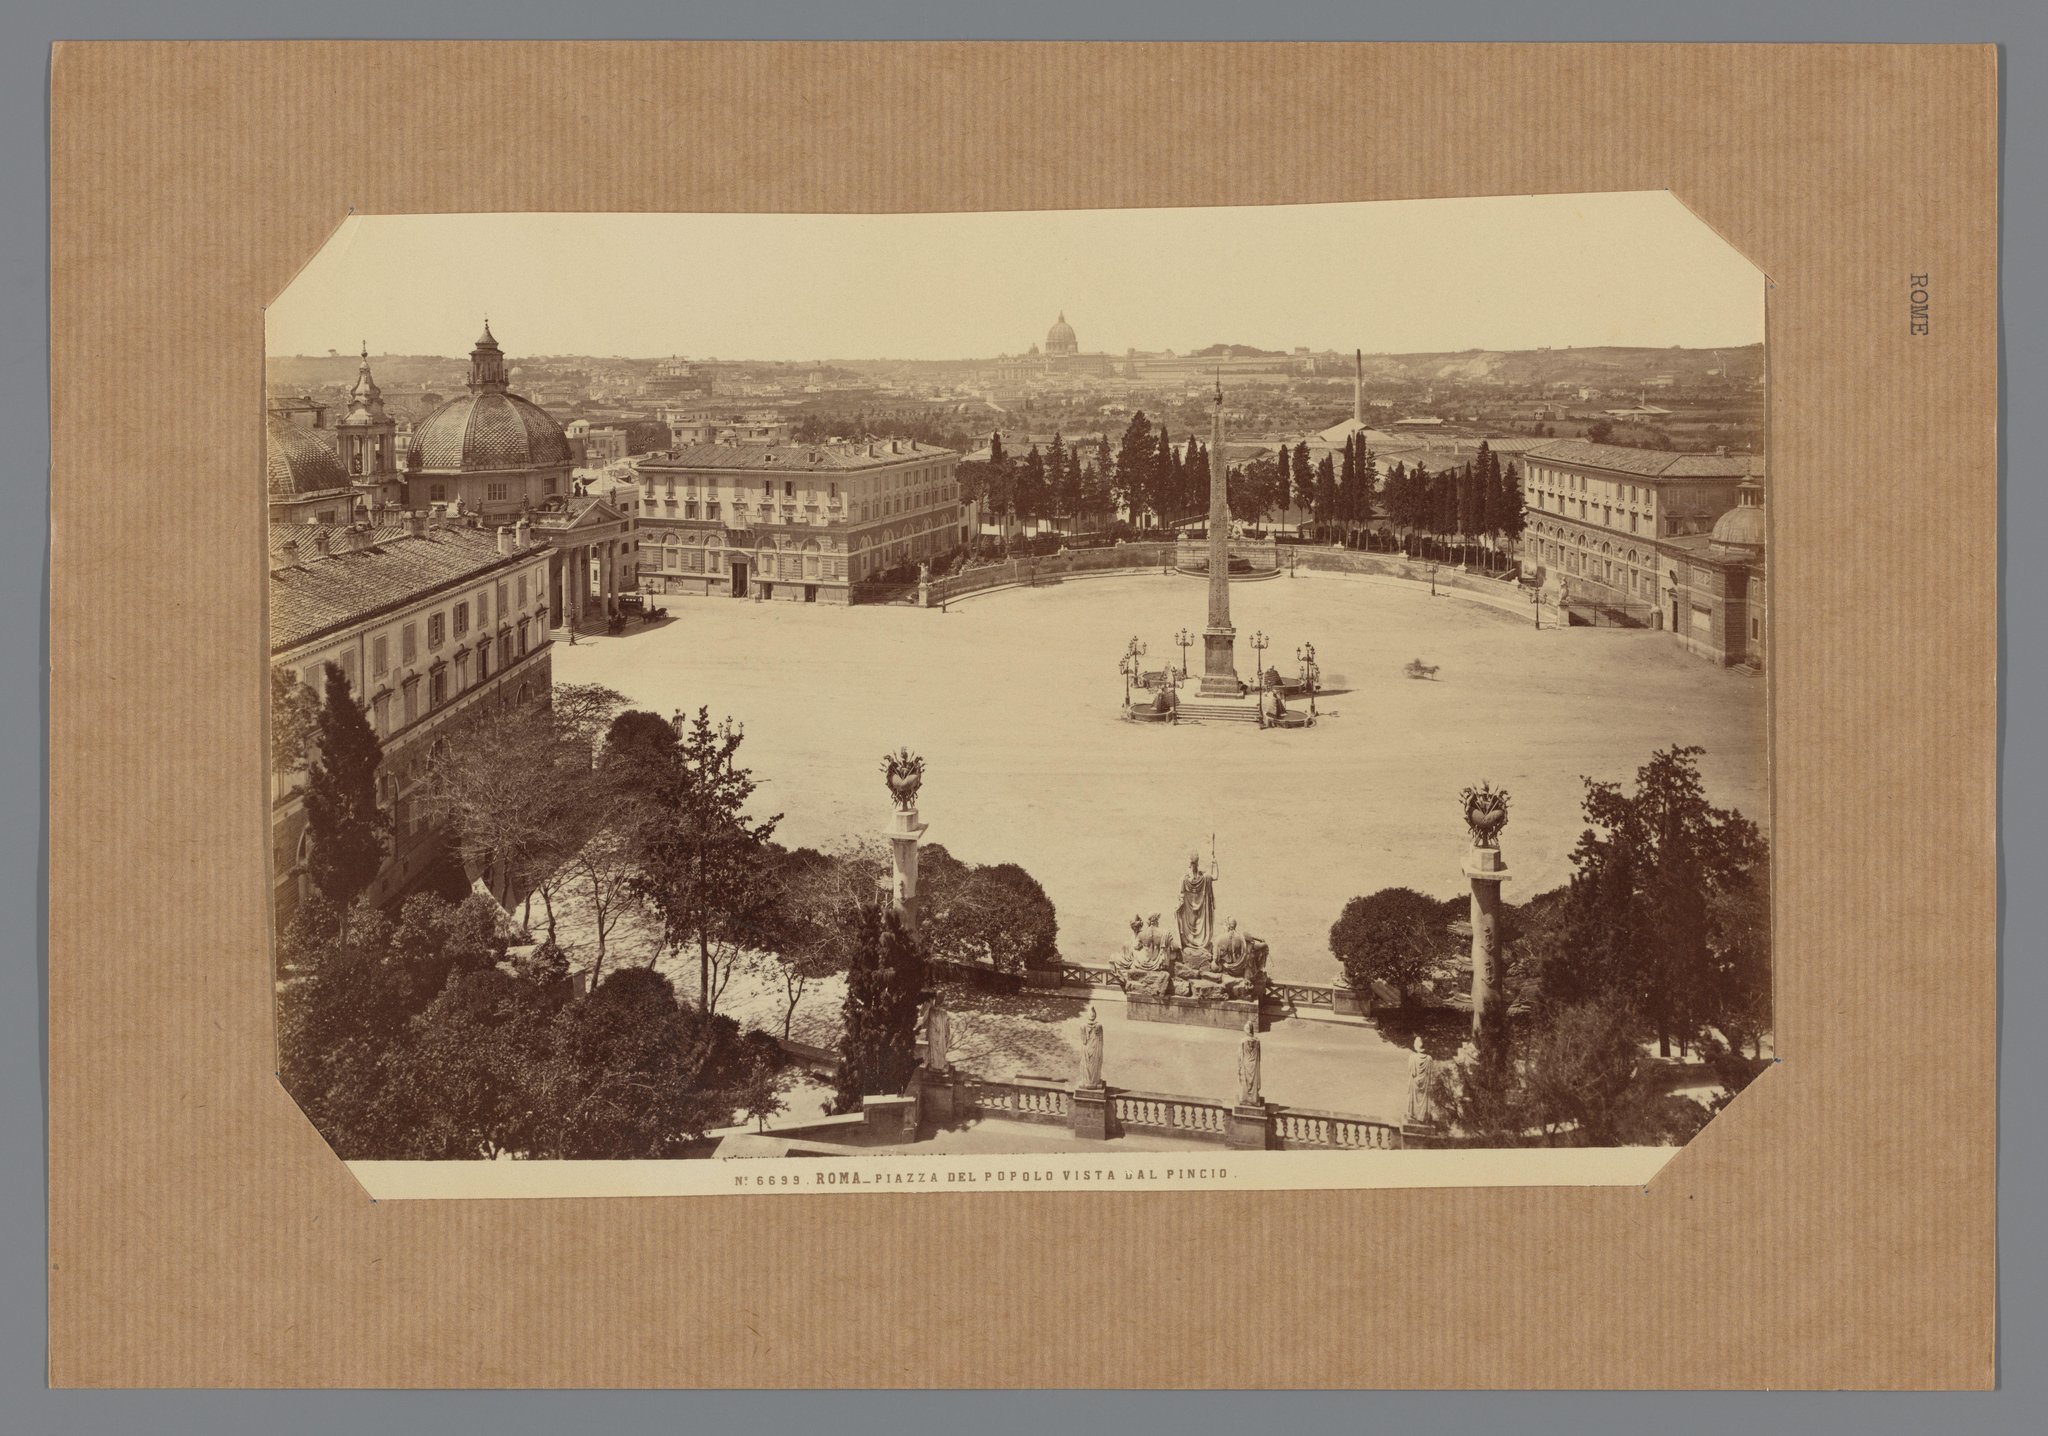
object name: photograph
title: Italië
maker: Anonymous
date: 1880-1910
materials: photographic support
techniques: albumen print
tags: italy